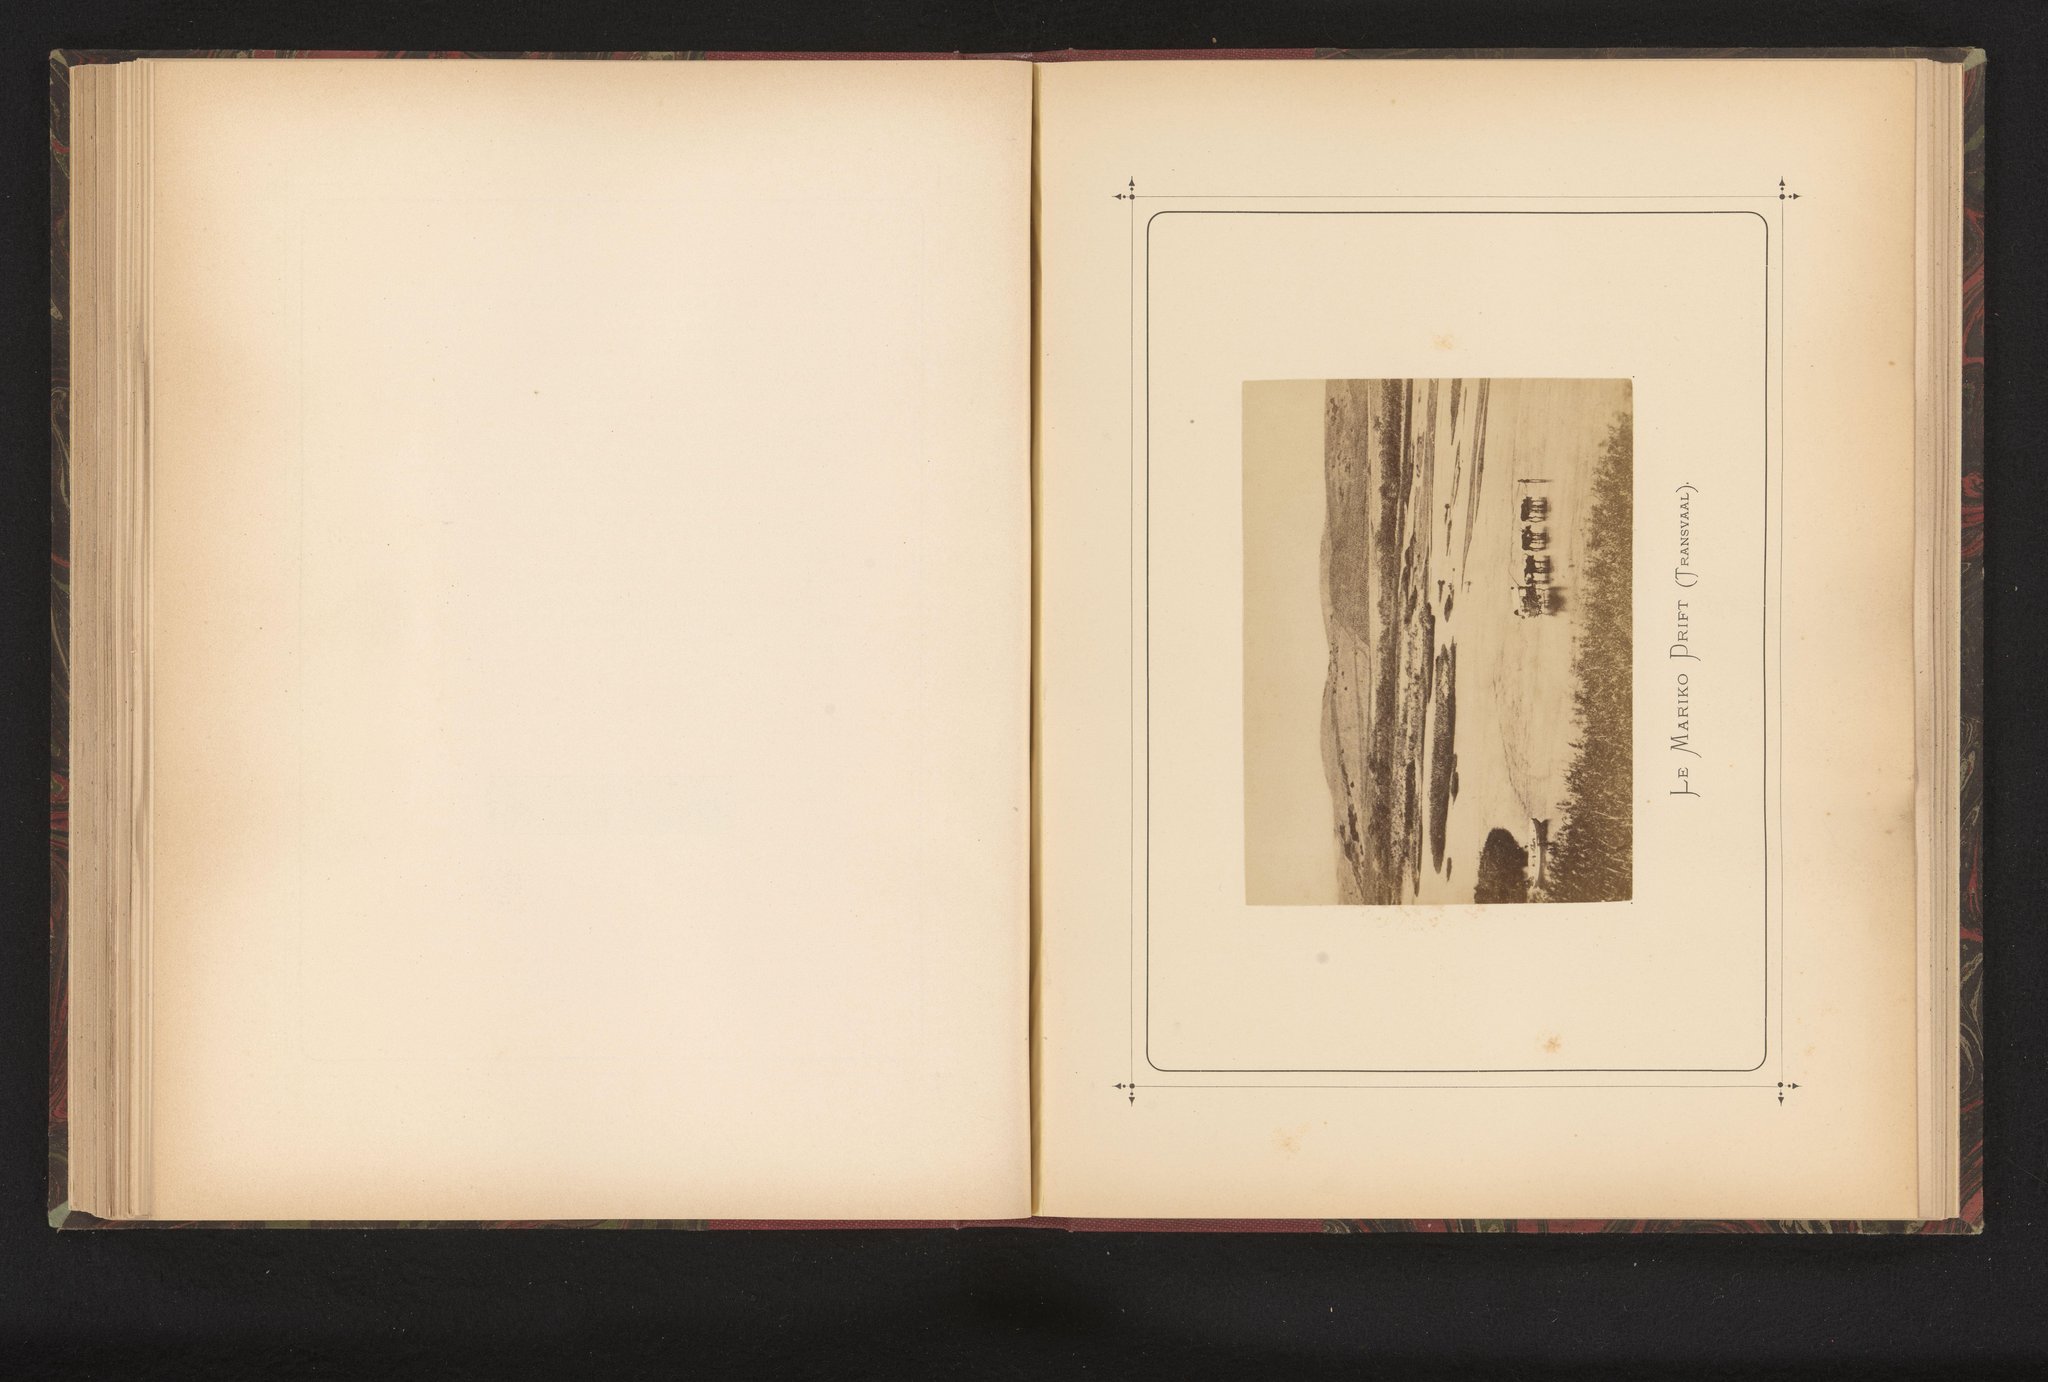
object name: photograph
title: Le Mariko Drift (Transvaal)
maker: Anonymous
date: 1879-1884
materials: paper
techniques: albumen print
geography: transvaal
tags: river, marico river